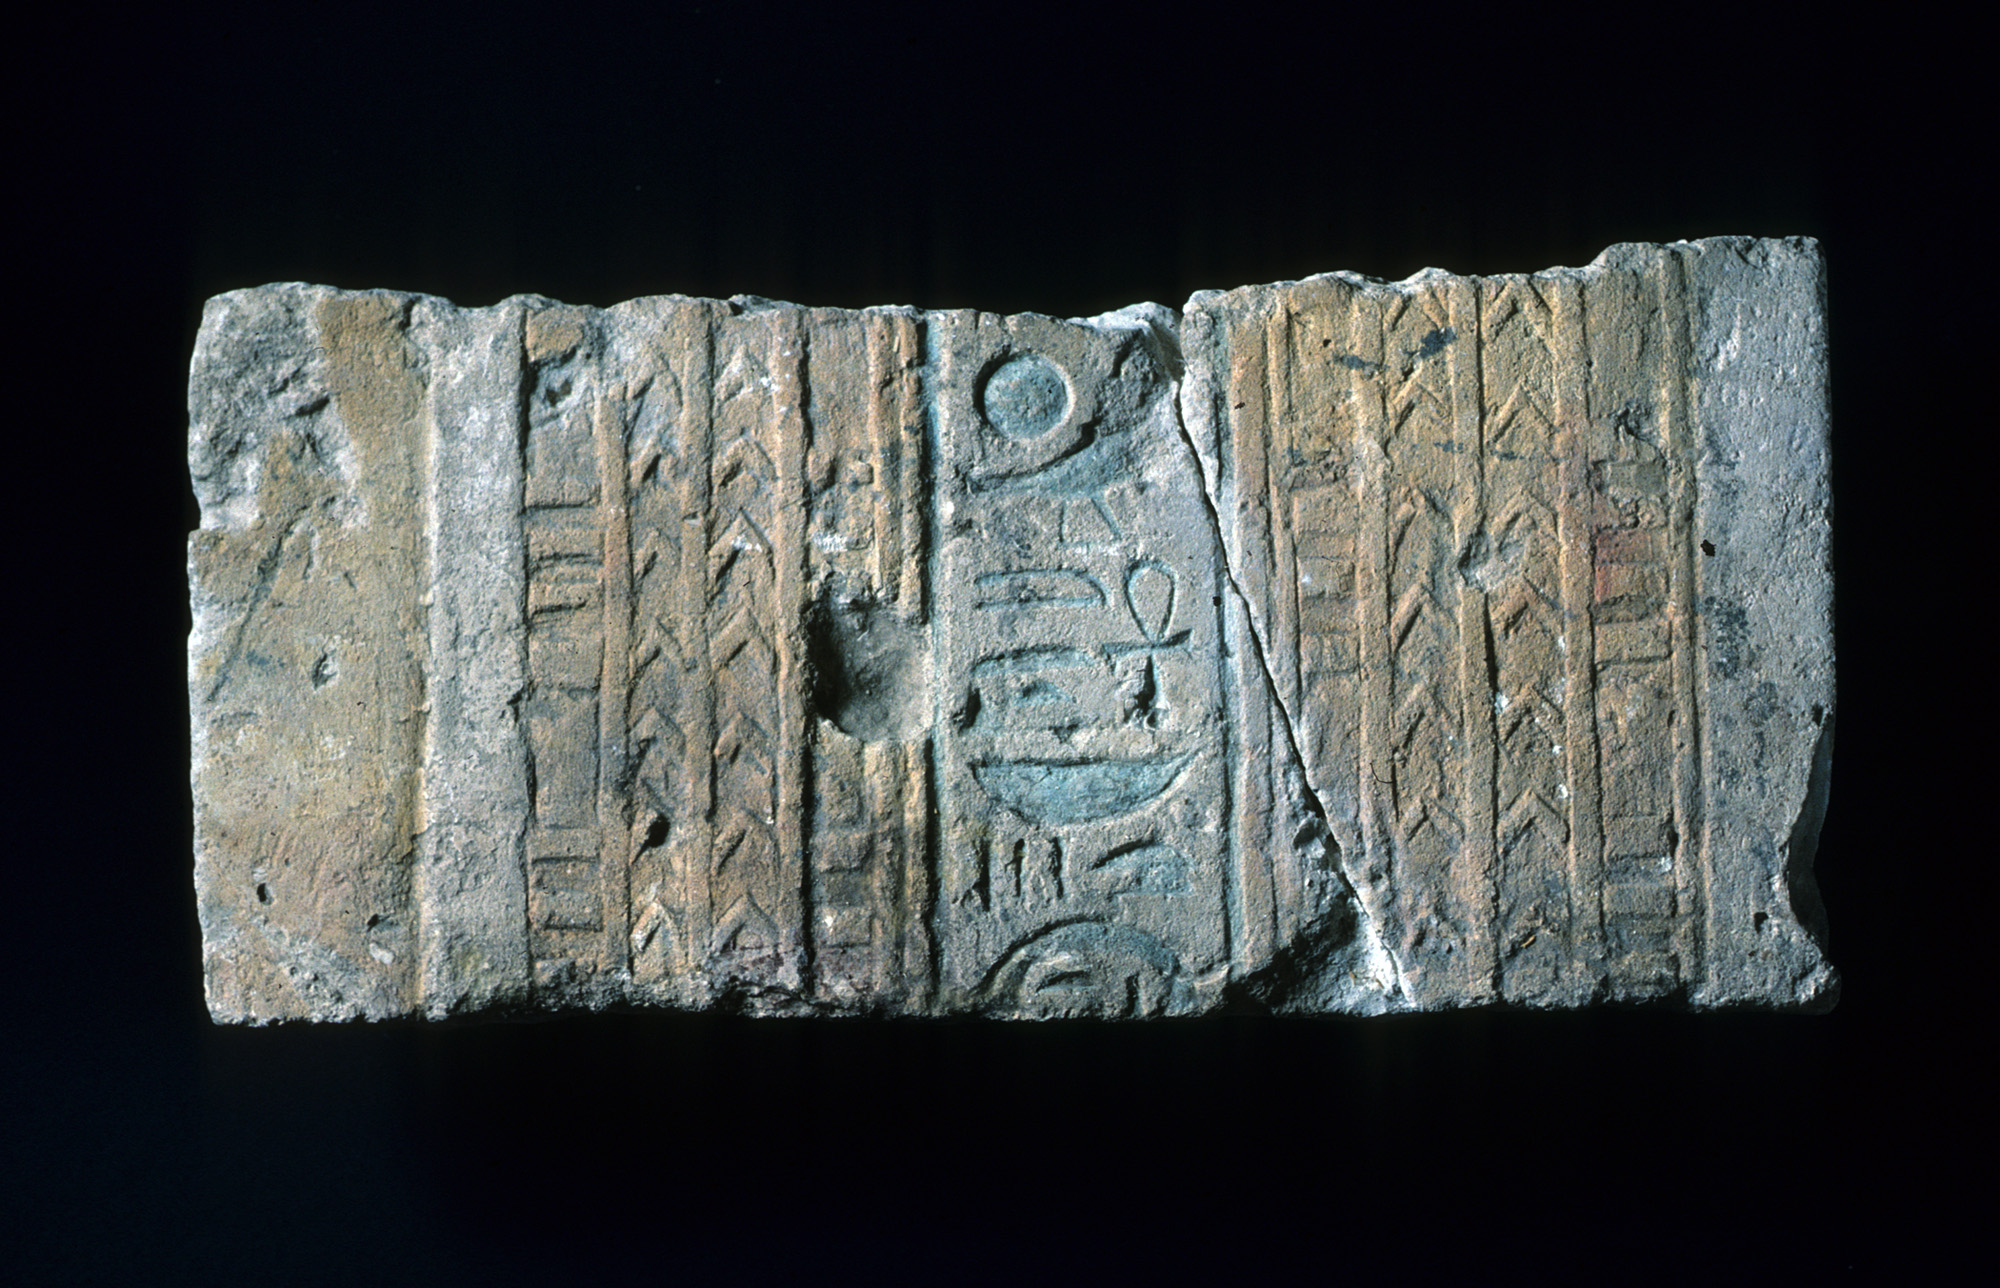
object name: talatat, akhenaten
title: Relief with titles of Akhenaten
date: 1353-1336 BCE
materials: limestone, paint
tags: hieroglyphs